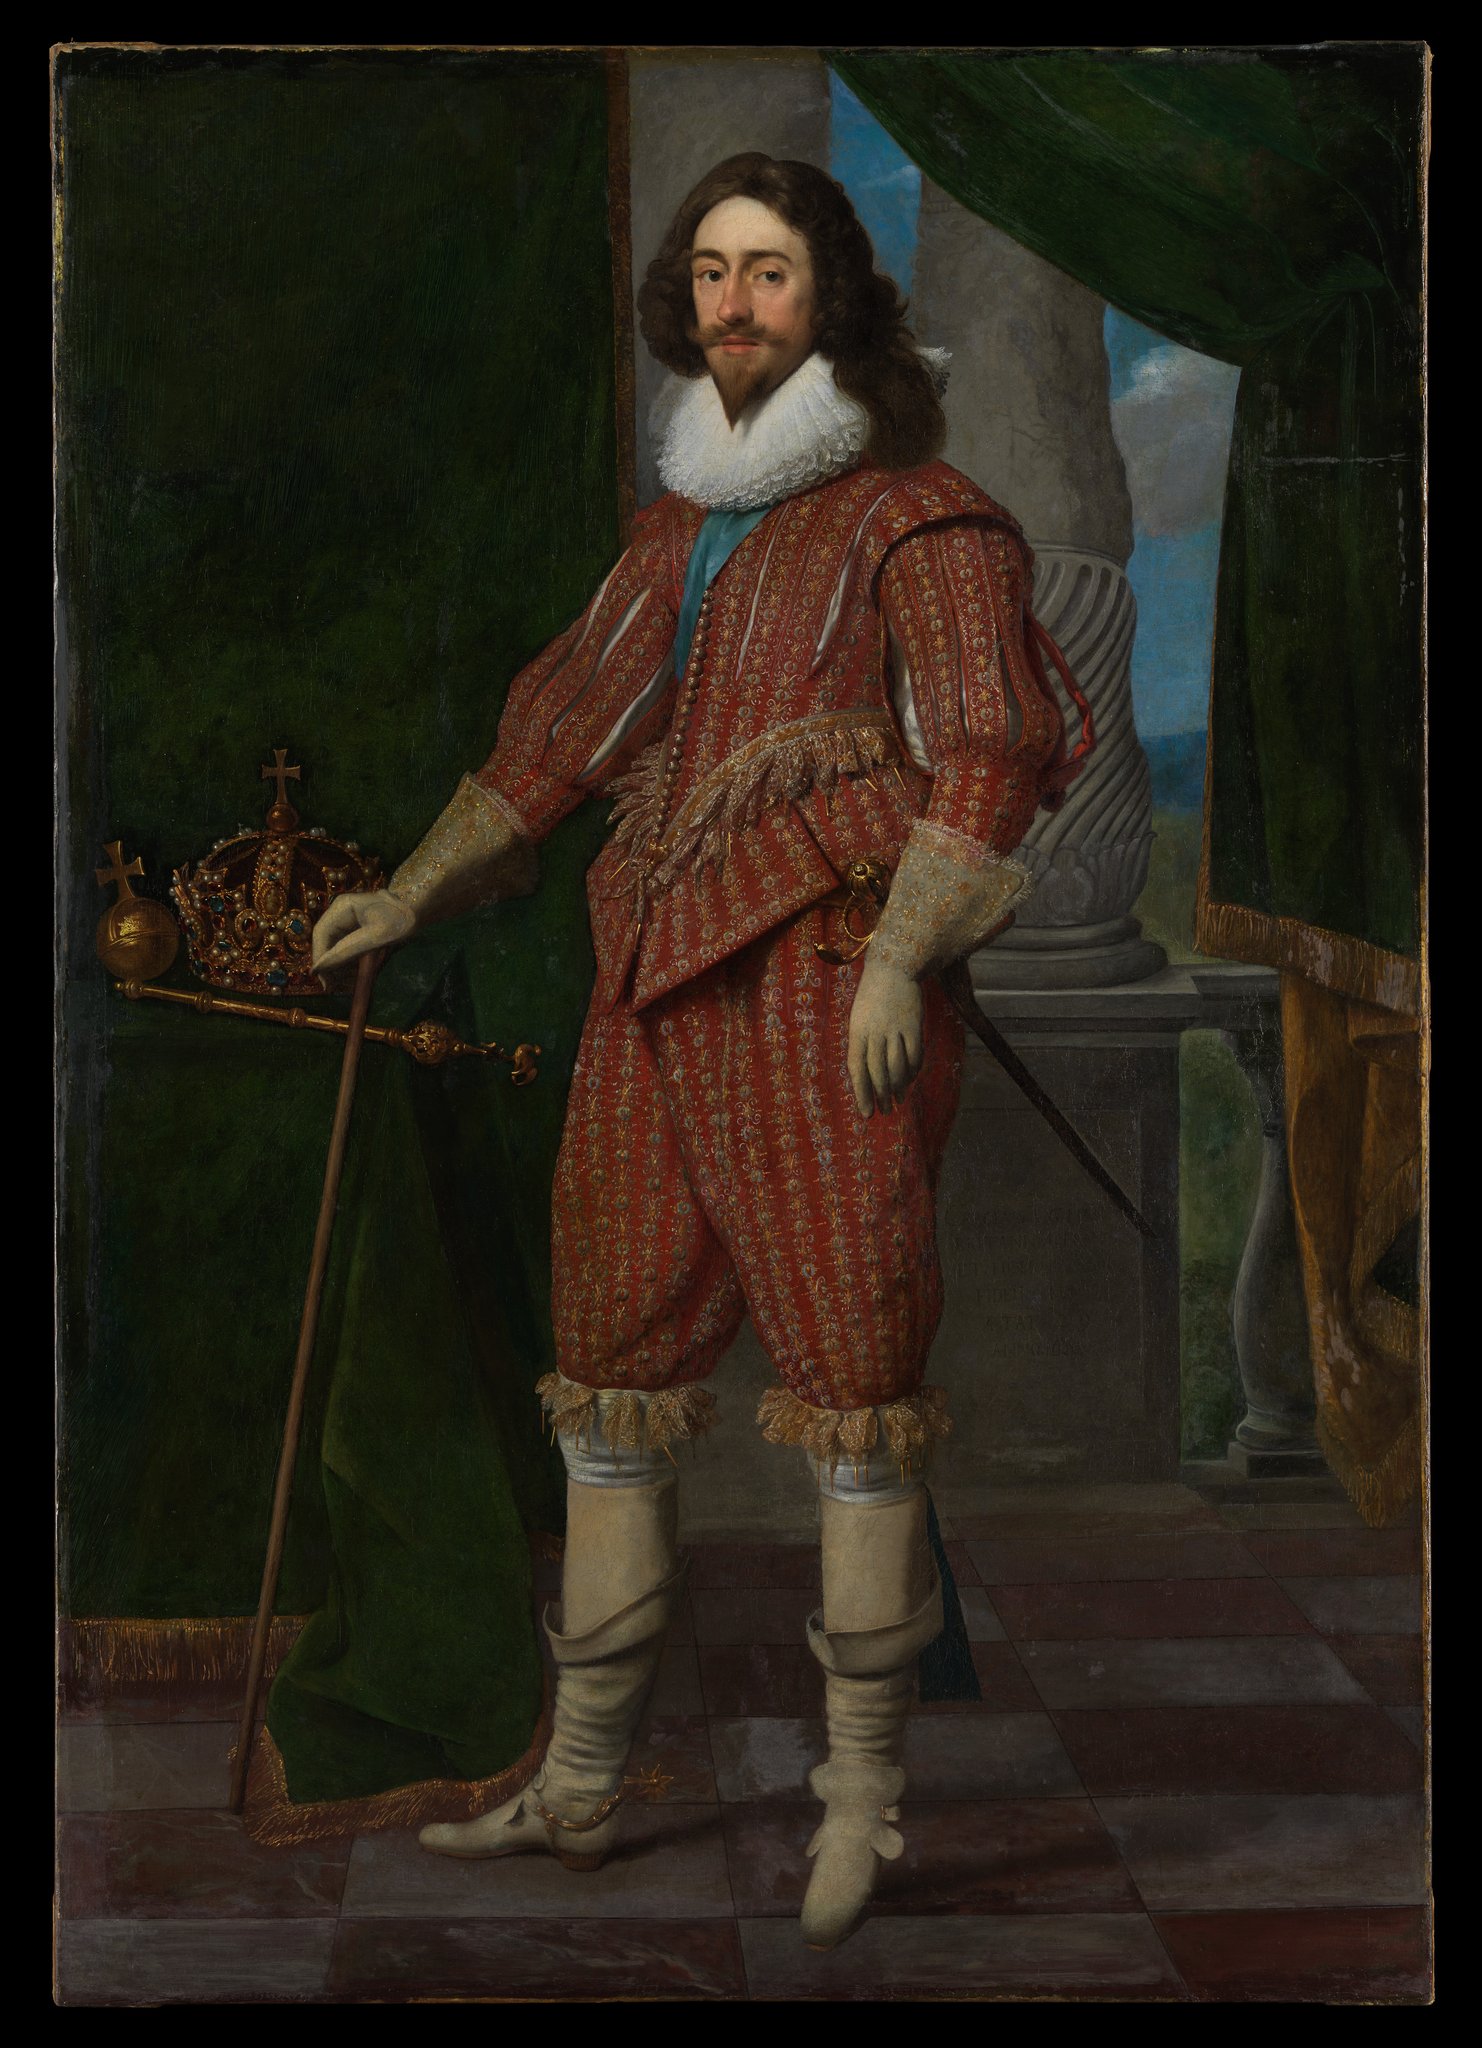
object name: painting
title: Charles I (1600–1649), King of England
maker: daniël mijtens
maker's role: artist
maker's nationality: dutch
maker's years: 1585-1648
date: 1629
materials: canvas, oil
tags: kings,men,portraits